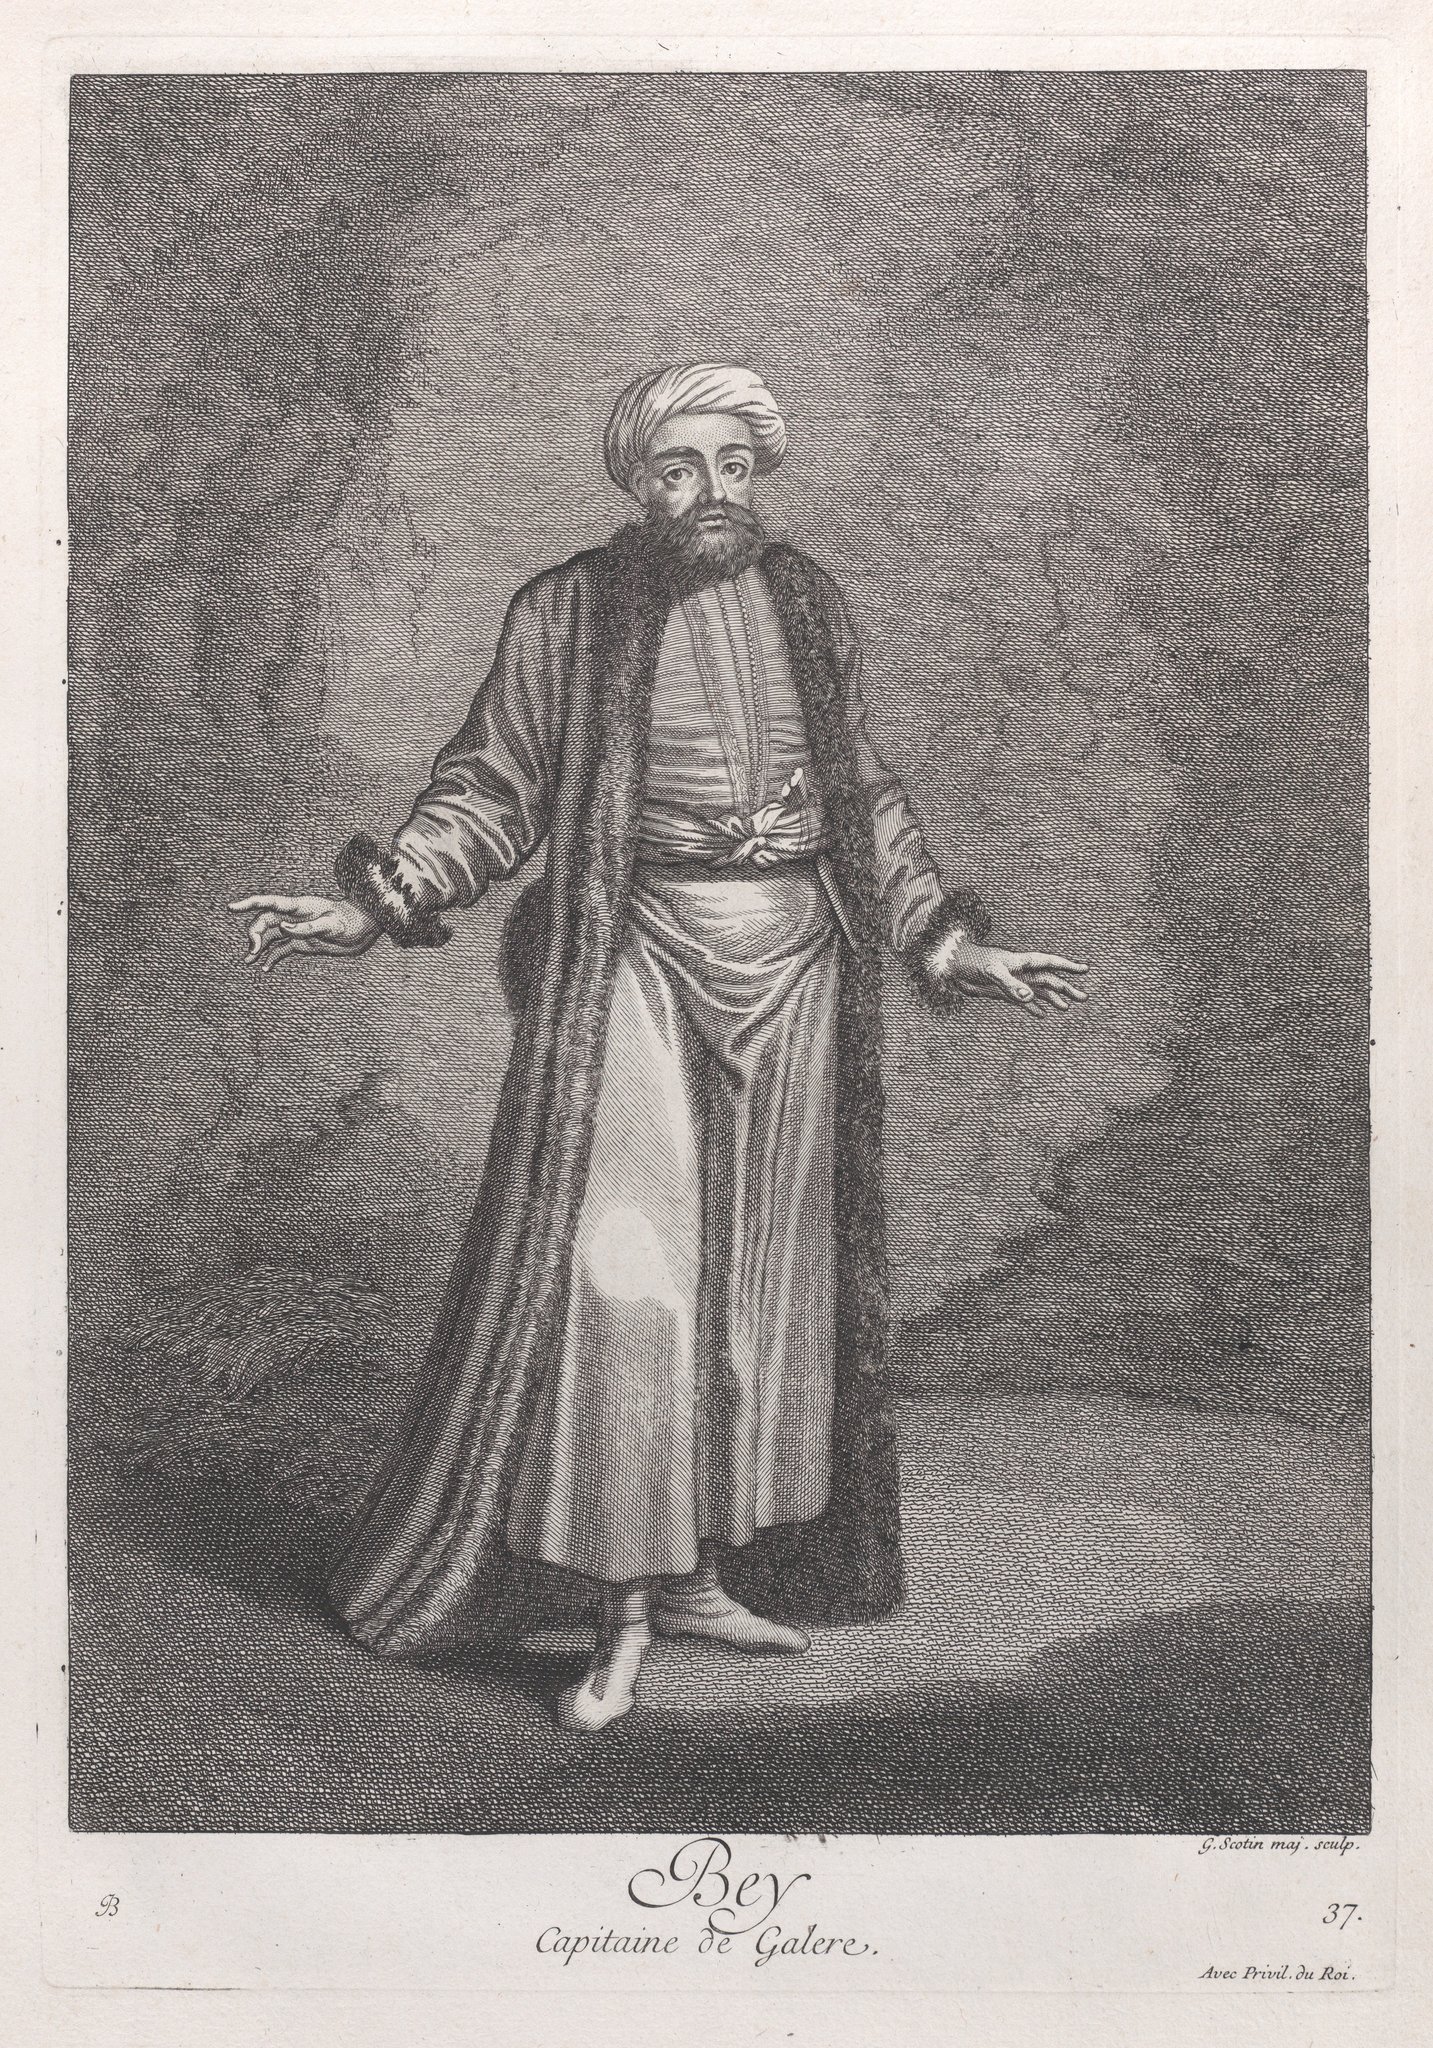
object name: print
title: Bey, Capitaine de Galere, plate 37 from "Recueil de cent estampes représentent differentes nations du Levant"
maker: jean baptiste vanmour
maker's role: artist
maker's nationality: french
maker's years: 1671-1737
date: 1714-1715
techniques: engraving, etching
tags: men